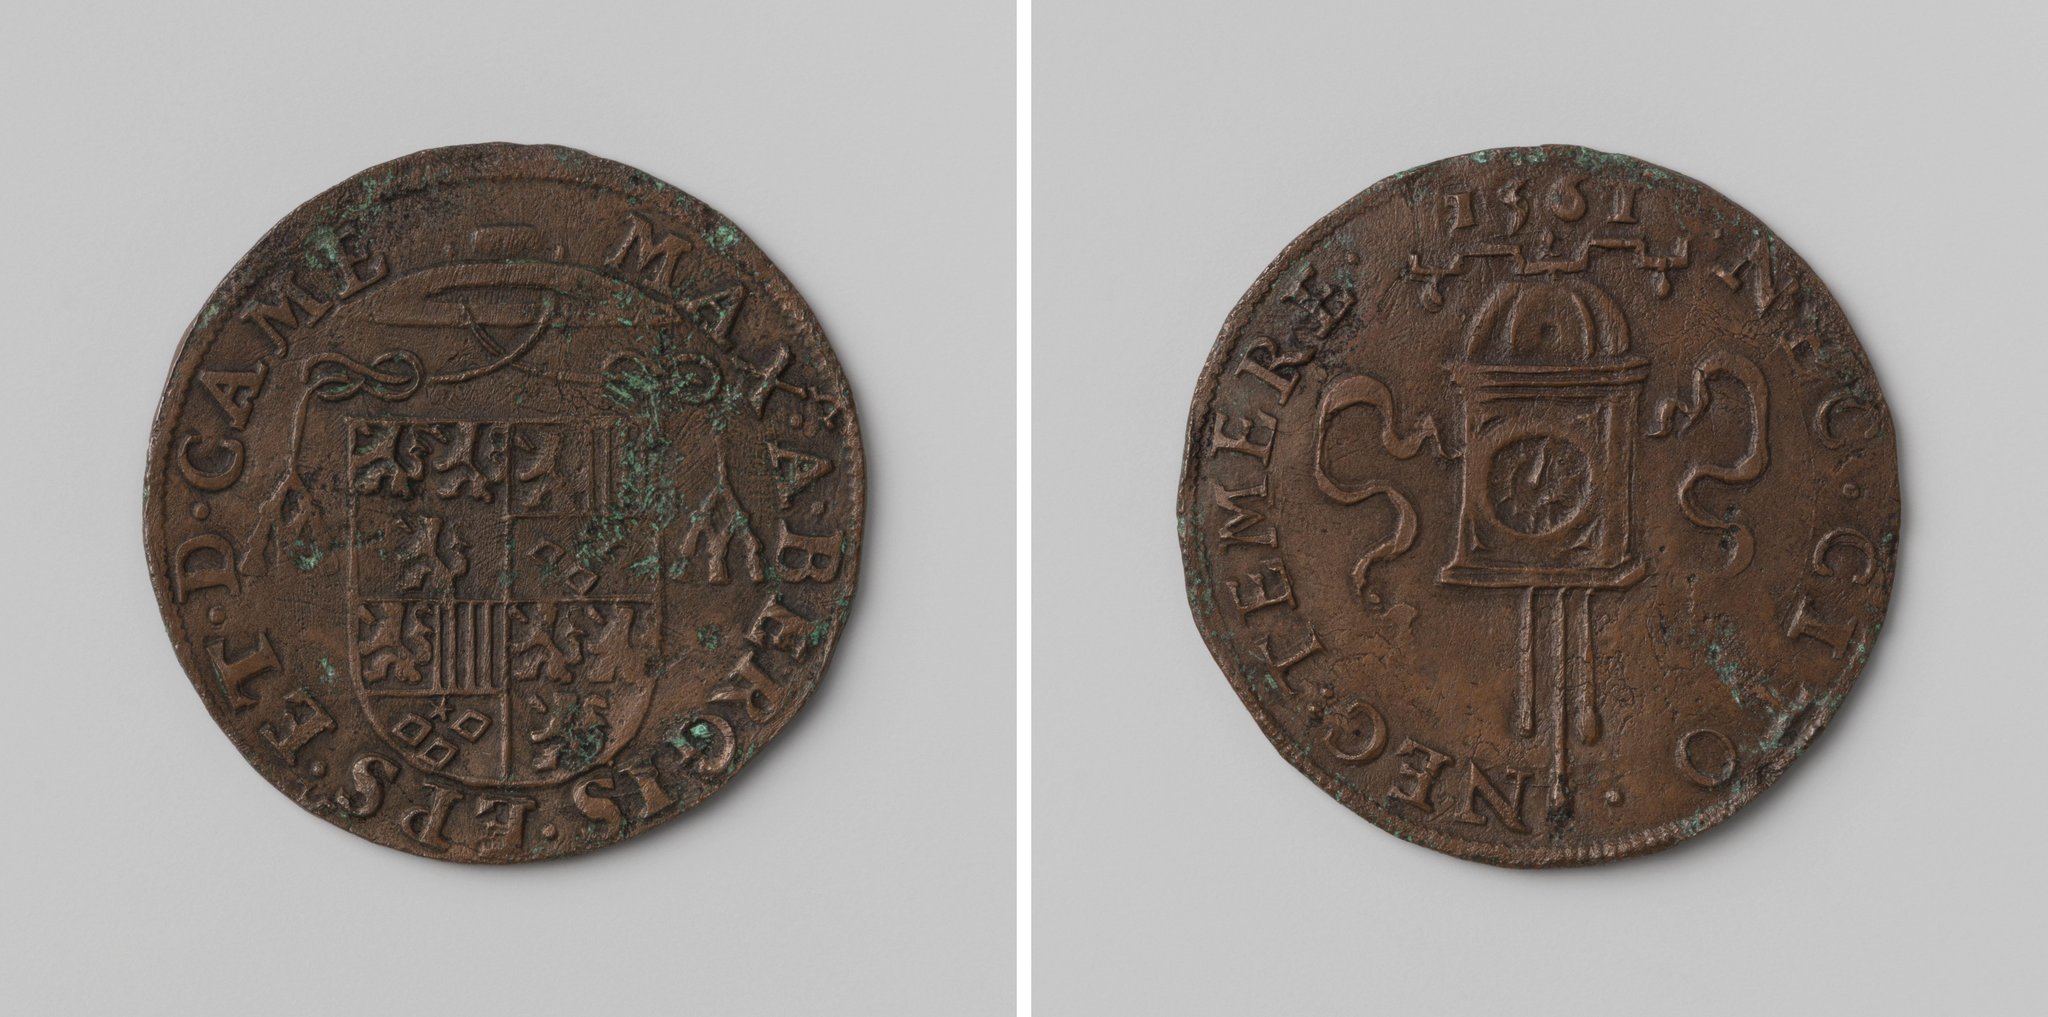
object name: jeton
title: Maximiliaan van Bergen, aartsbisschop van Kamerijk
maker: Anonymous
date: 1561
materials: copper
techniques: striking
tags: aartsbisschop, aartsbisschop van kamerijk maximiliaan van bergen, cambrai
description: Koperen penning. Voorzijde: wapenschild onder kardinaalshoed binnen omschrift. Keerzijde: pendule binnen omschrift